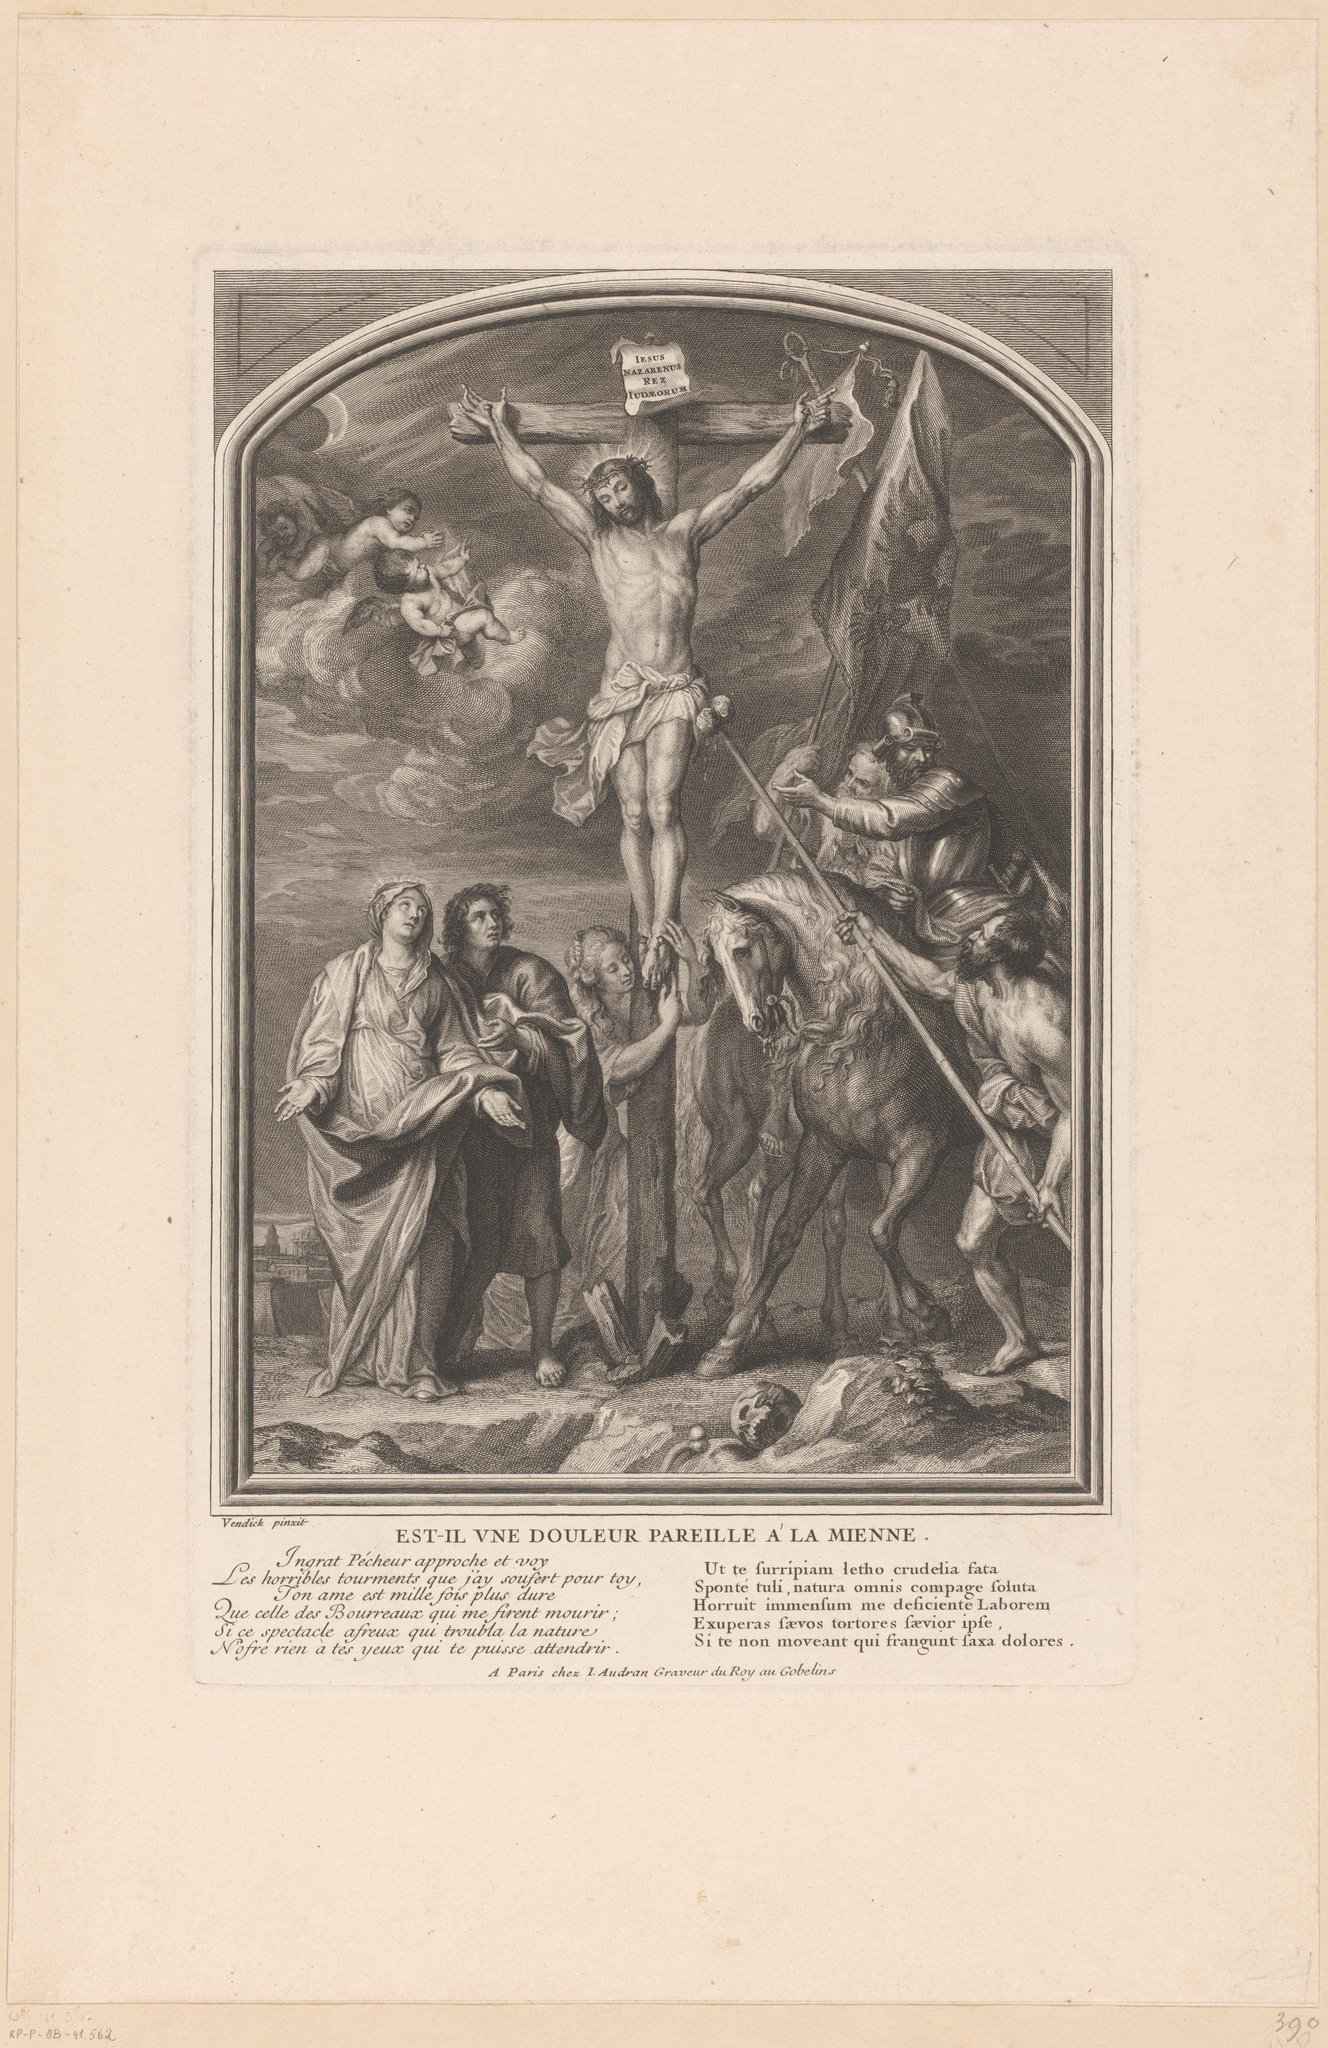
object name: print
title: Kruisiging van Christus met lanssteek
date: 1677-1756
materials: paper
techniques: engraving, etching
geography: france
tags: the soldier longinus (the centurion) of caesarea; possible attributes: lance, pyx, christ on the cross; only scenes following the crucifixion added - dd - the three crosses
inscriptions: collector's mark: Lugt 240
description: Kruisiging van Christus met de lanssteek door Longinus.